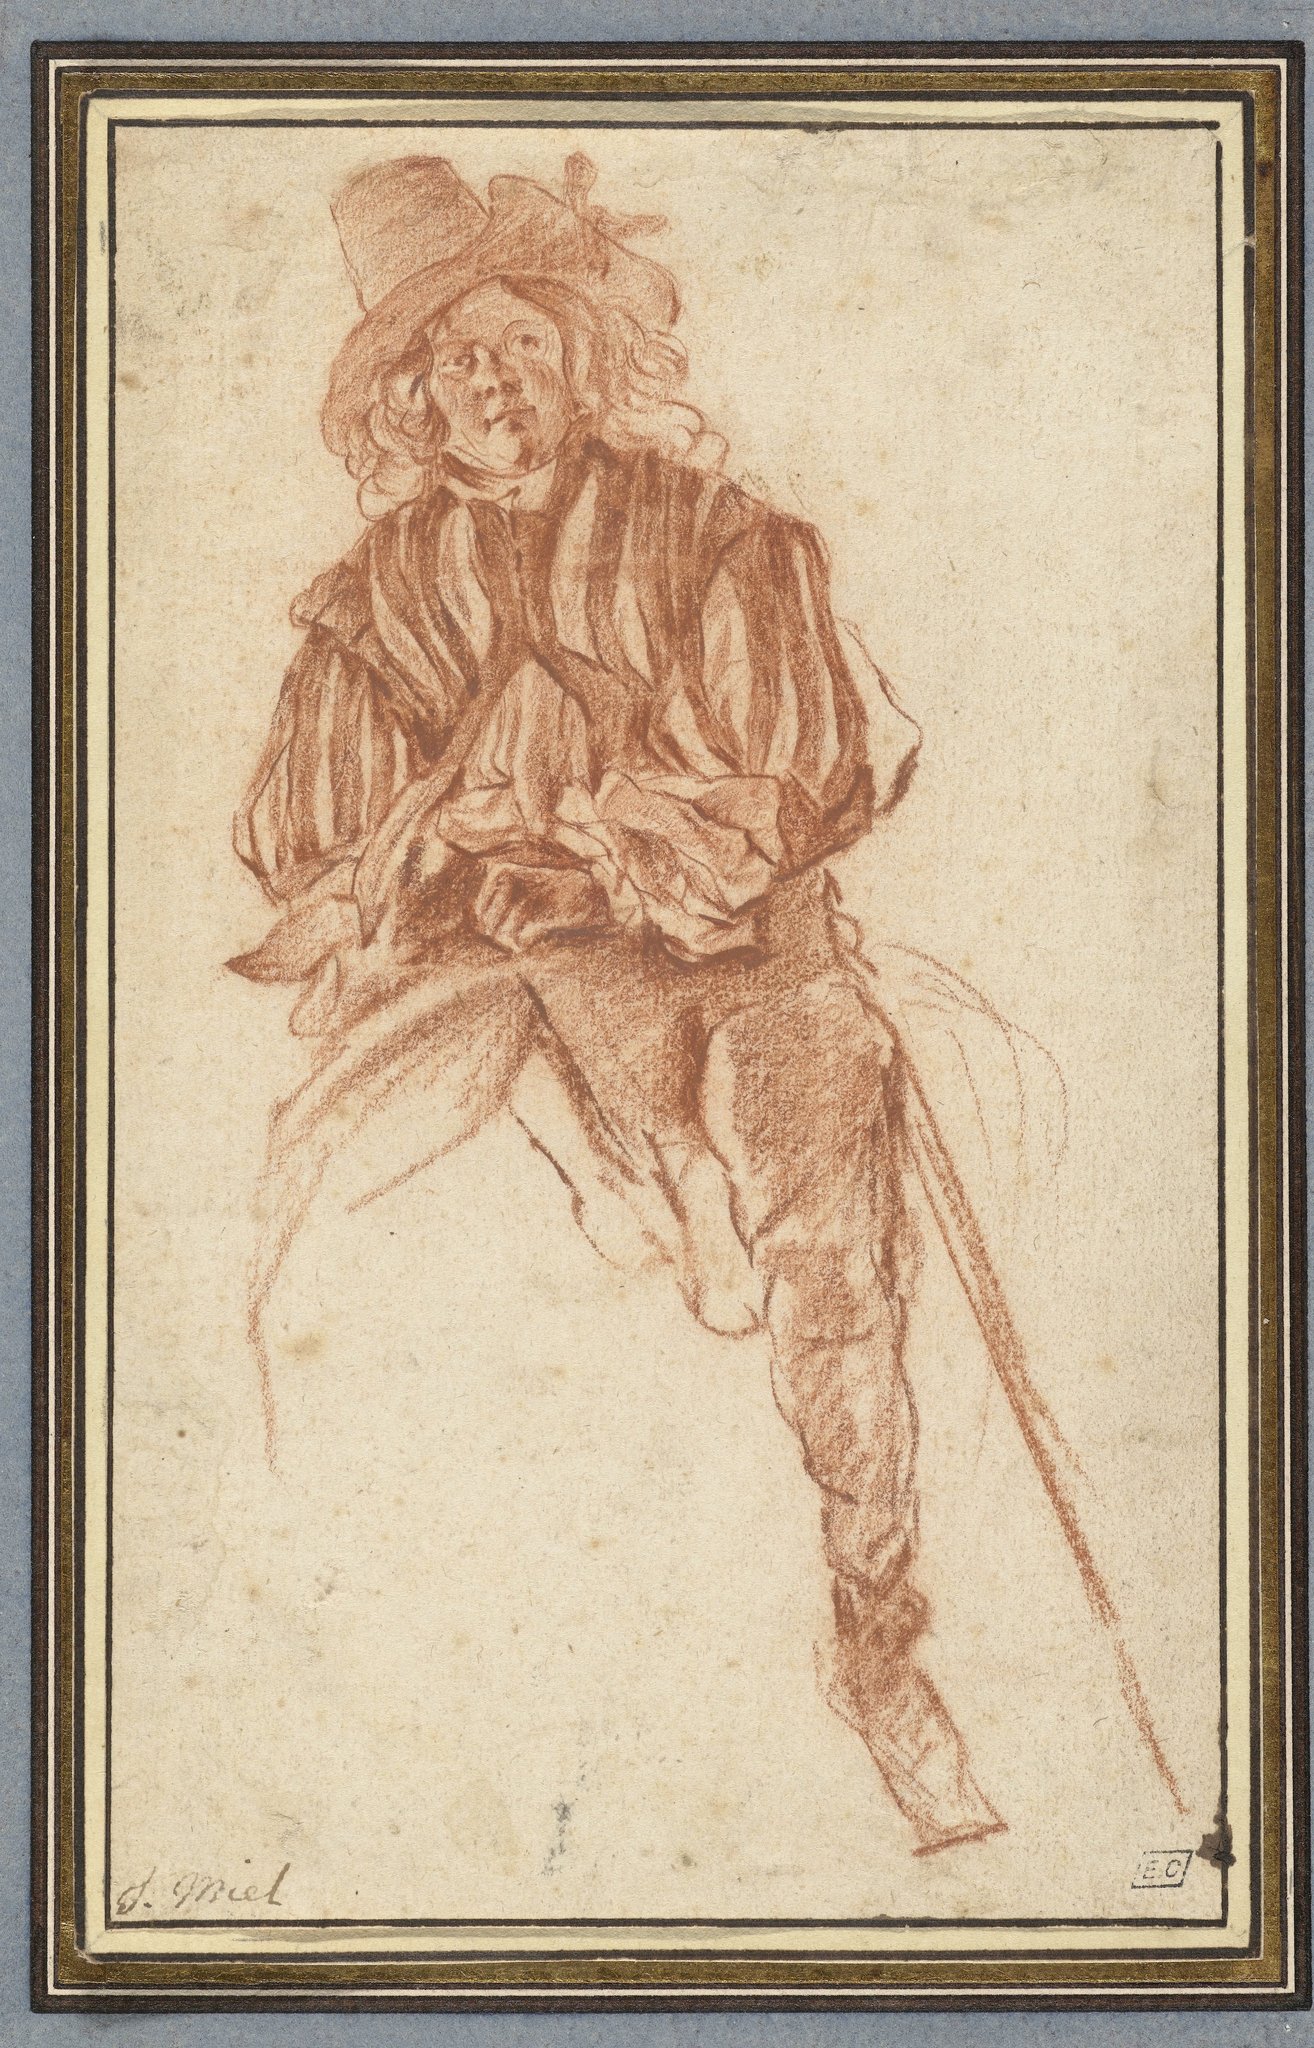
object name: drawing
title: Te paard zittende jonge ruiter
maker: jan miel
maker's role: draughtsman, painter, print maker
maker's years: 1599-1663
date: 1610-1663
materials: chalk, paper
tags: riding a horse, ass, or mule; rider, horseman, boy (child between toddler and youth)